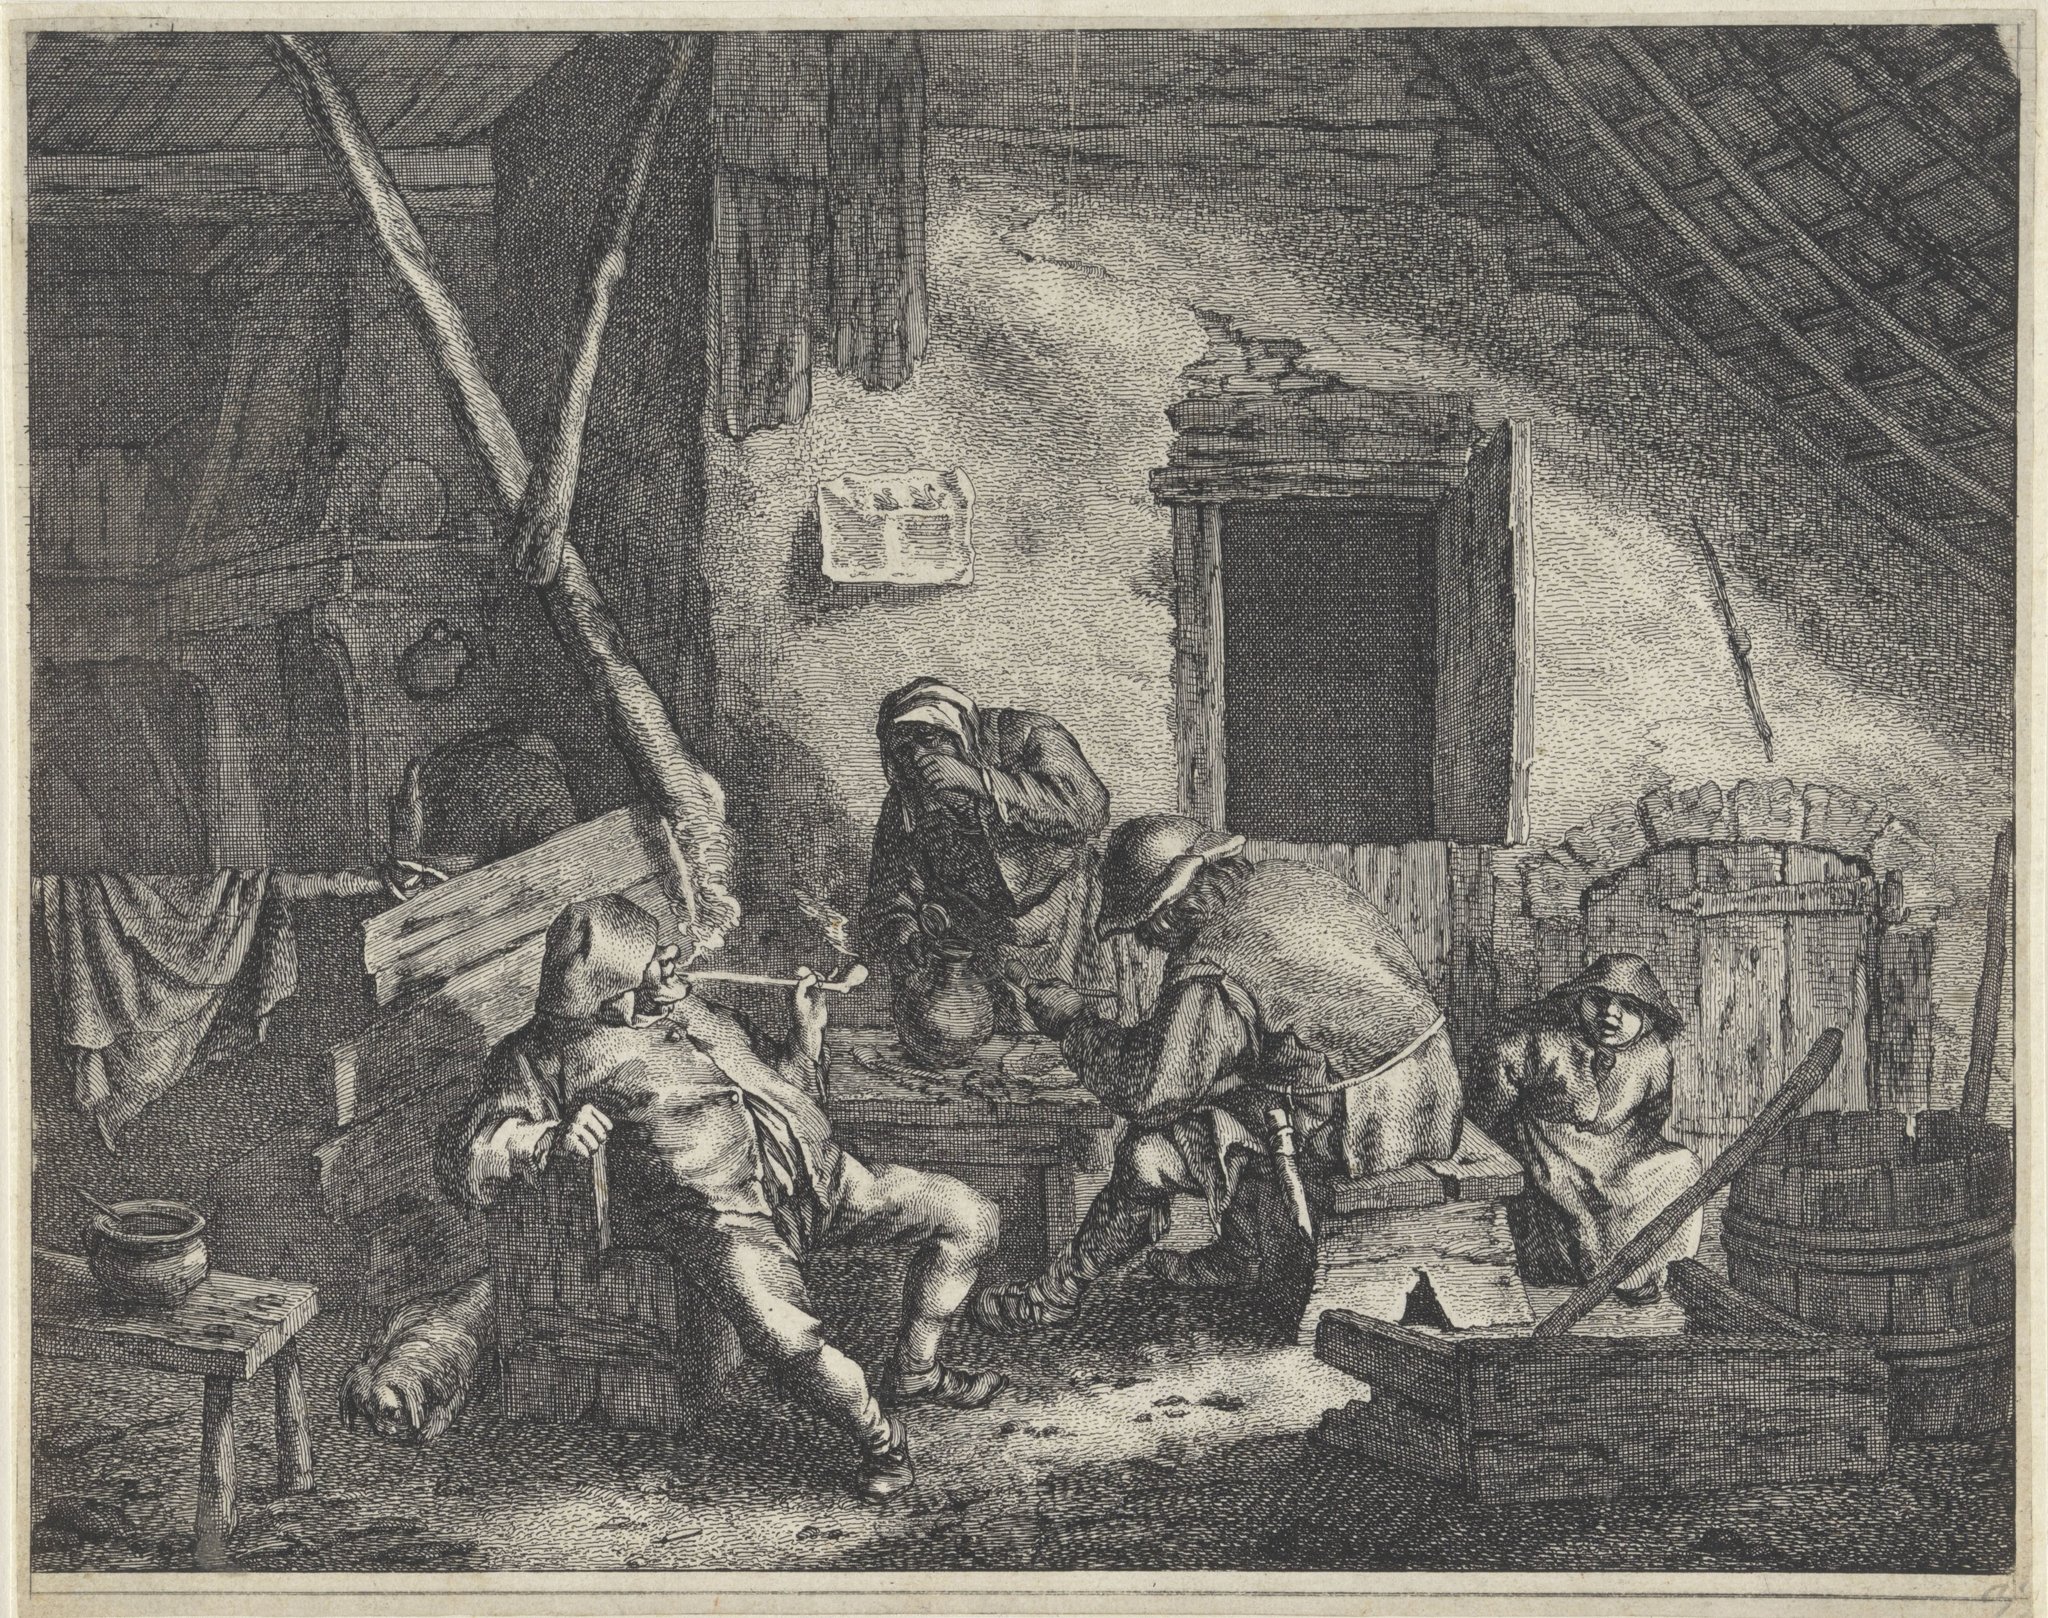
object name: print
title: Vijf figuren in een herberg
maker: jan de visscher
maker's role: print maker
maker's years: 1633-1712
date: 1643-1692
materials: paper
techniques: etching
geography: northern netherlands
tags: inn, coffee-house, public house, etc., pipe ~ tobacco, dog, printed matter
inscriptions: collector's mark: Lugt 240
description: In een rommelige herberg bevinden zich vijf figuren en een hond. Drie van hen zitten aan tafel te roken en te drinken. Aan de muur hangt een prent met een afbeelding van een zwaan en tekst.